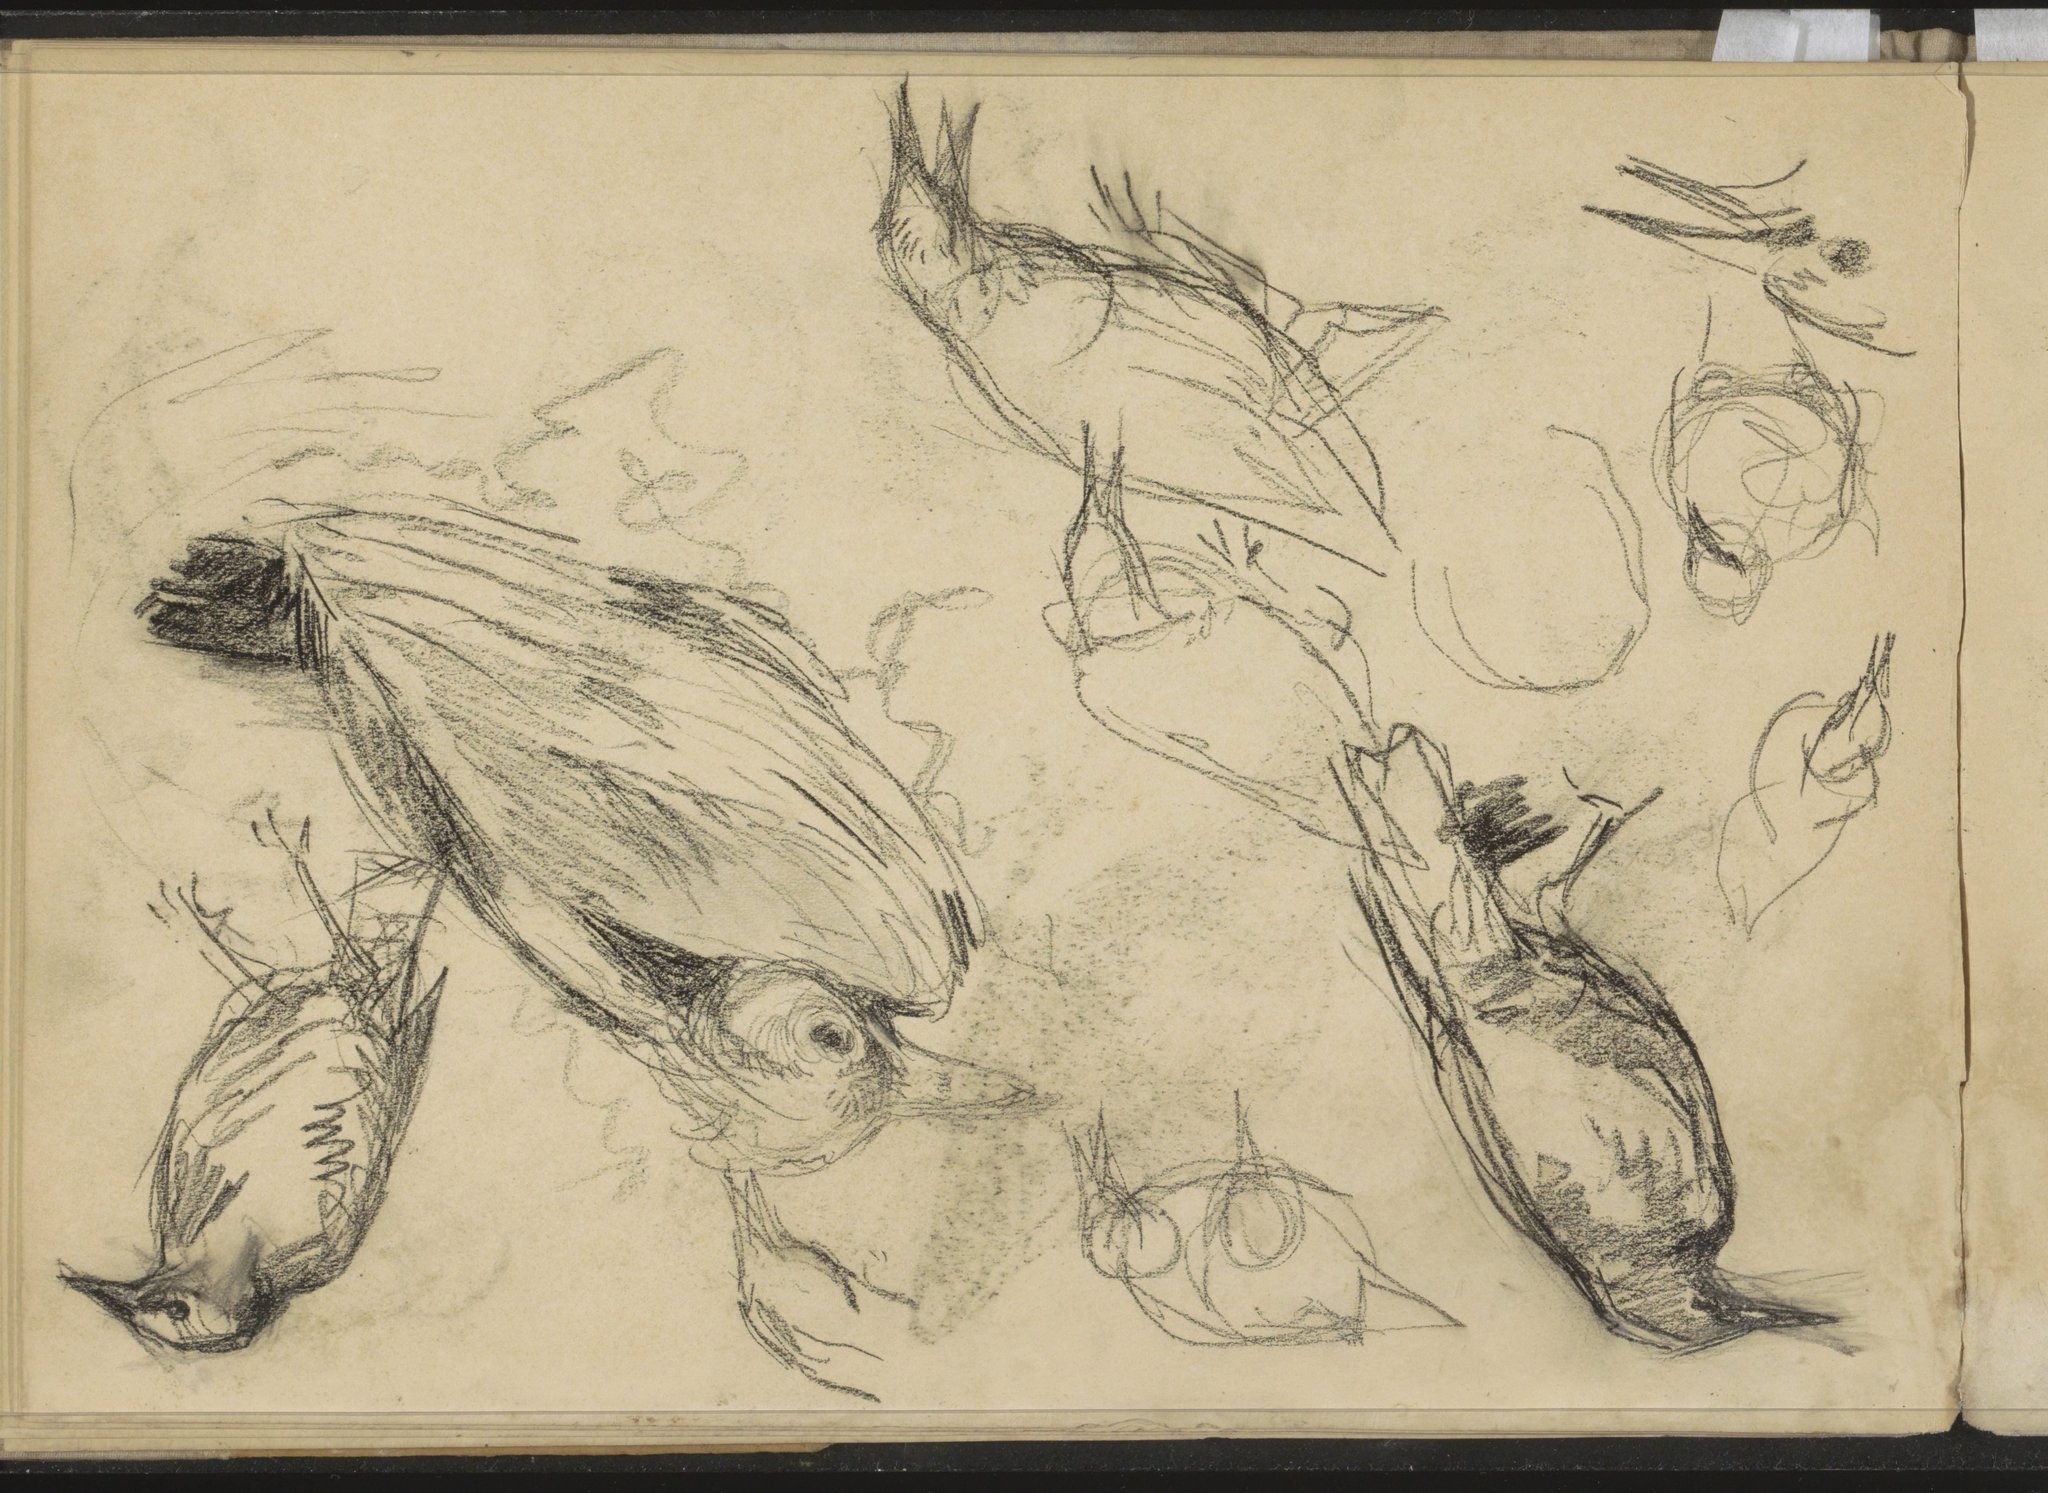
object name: sketchbook leaf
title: Vogels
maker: willem bastiaan tholen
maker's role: draughtsman, painter, print maker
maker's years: 1860-1931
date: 1885-1931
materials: chalk, paper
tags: birds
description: Blad 20 verso uit een schetsboek met 28 bladen.